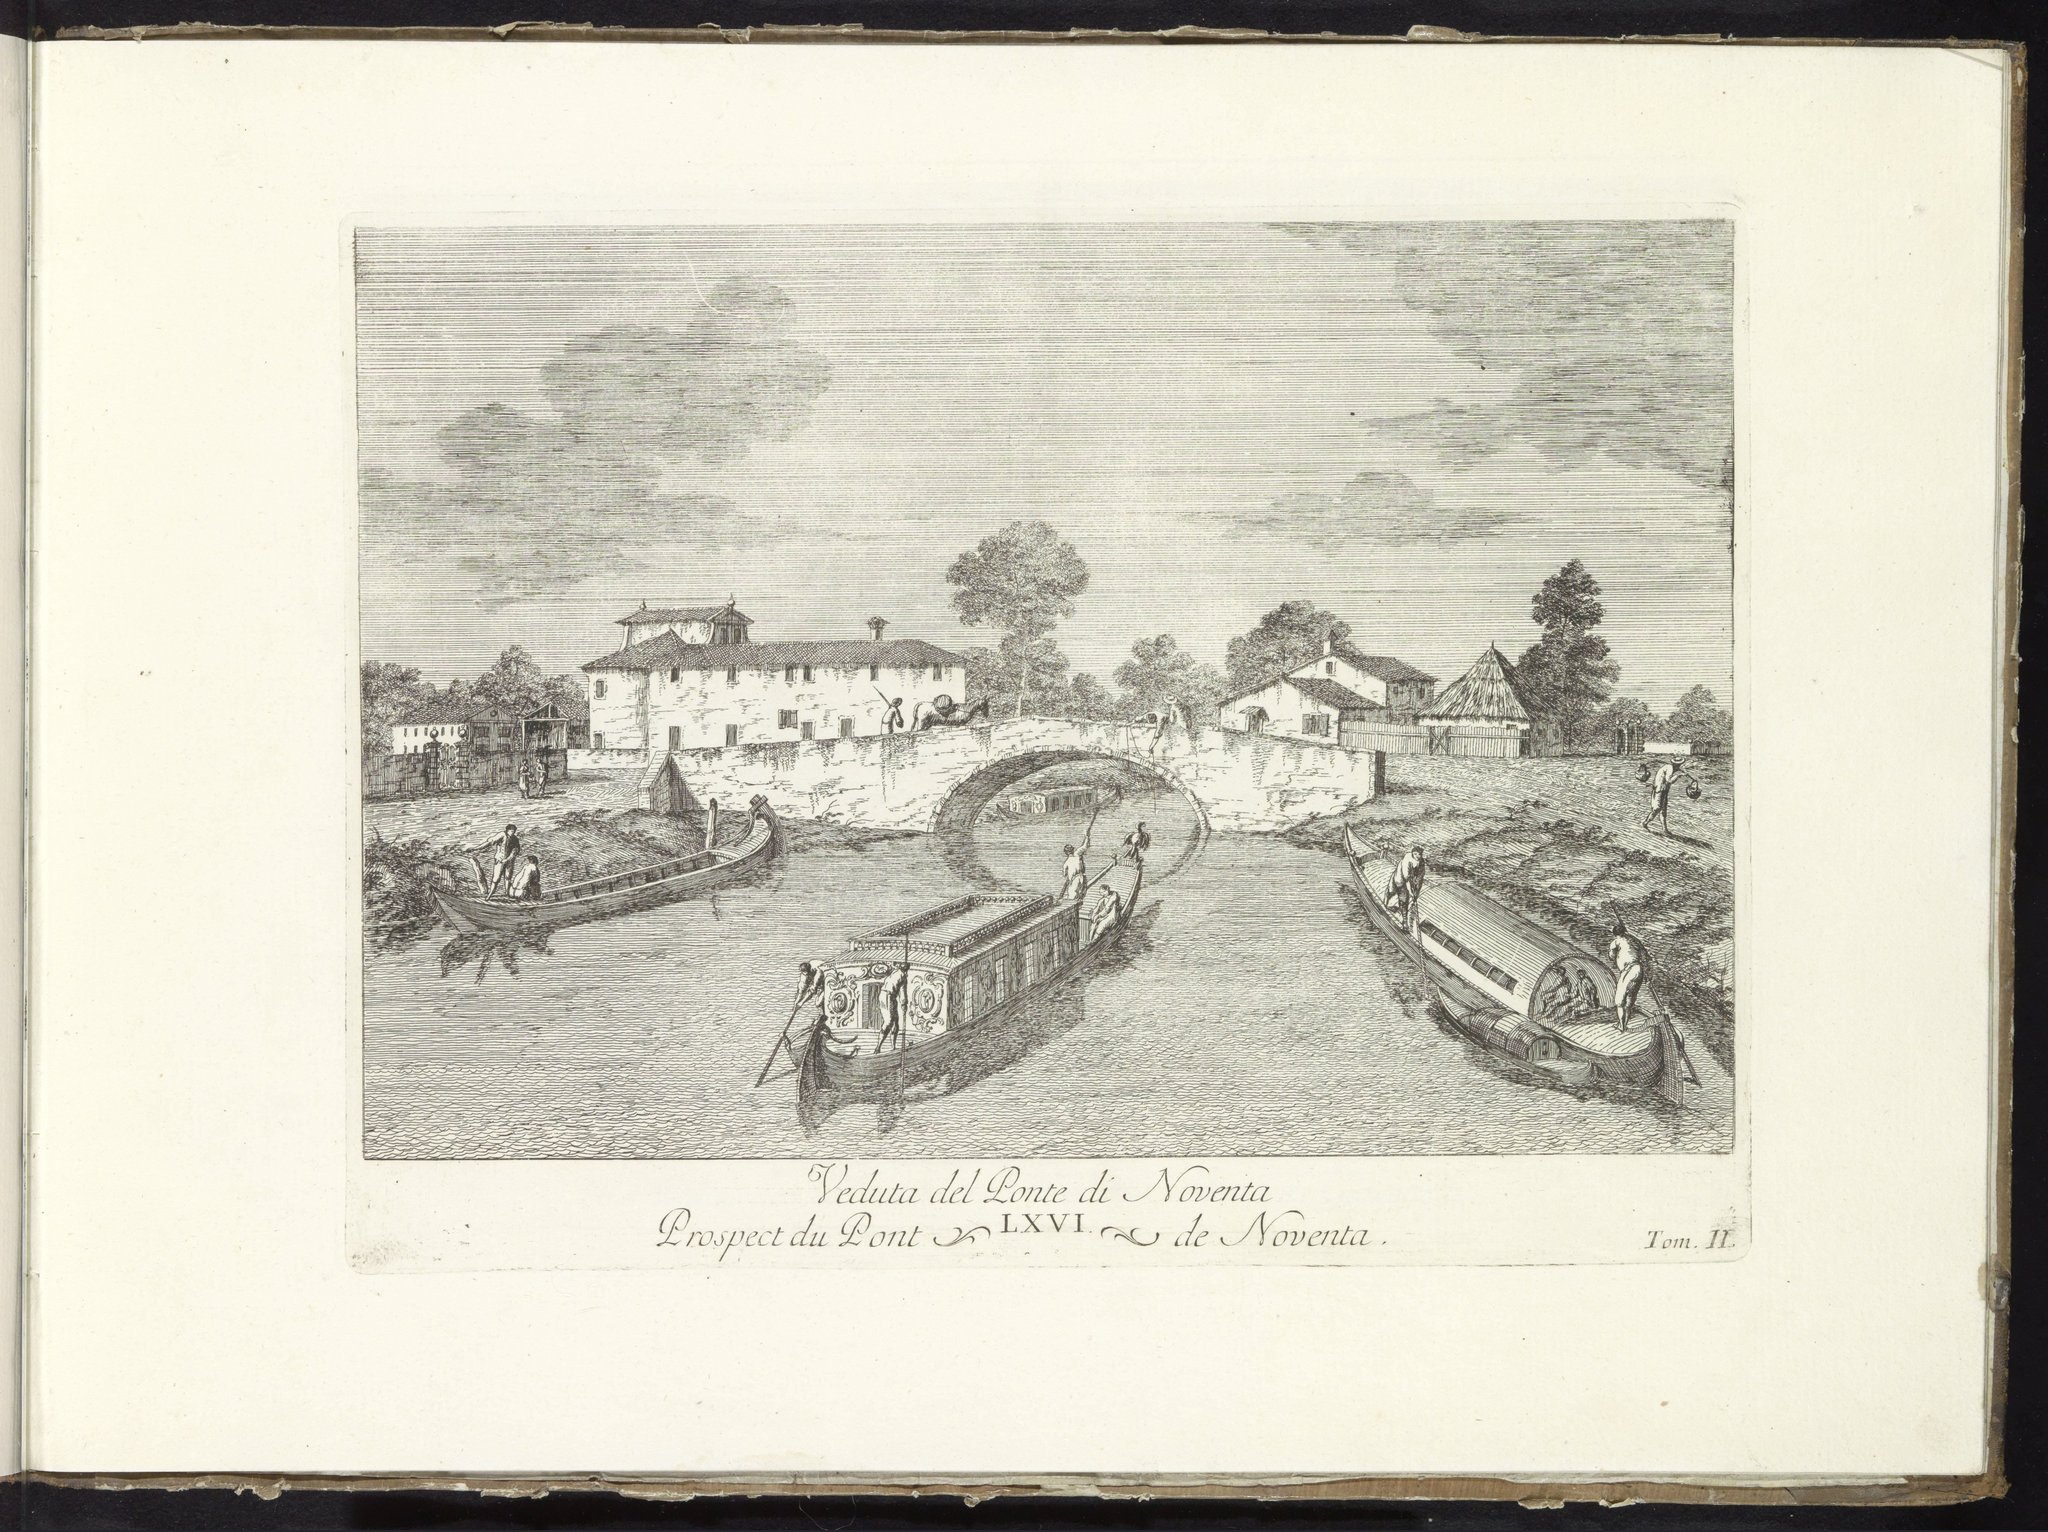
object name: print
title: Le delicie della Brenta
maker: giovanni francesco costa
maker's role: draughtsman, painter, print maker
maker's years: -1773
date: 1750-1760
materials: paper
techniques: etching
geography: italy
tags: river, landscape with bridge, viaduct or aqueduct, gondola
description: Gezicht op de brug over de rivier de Brenta te Noventa. Drie schuiten liggen voor de brug in het water. Genummerd midden onder: LXVI en rechtsonder: Tom: II. Deze prent maakt deel uit van een album.